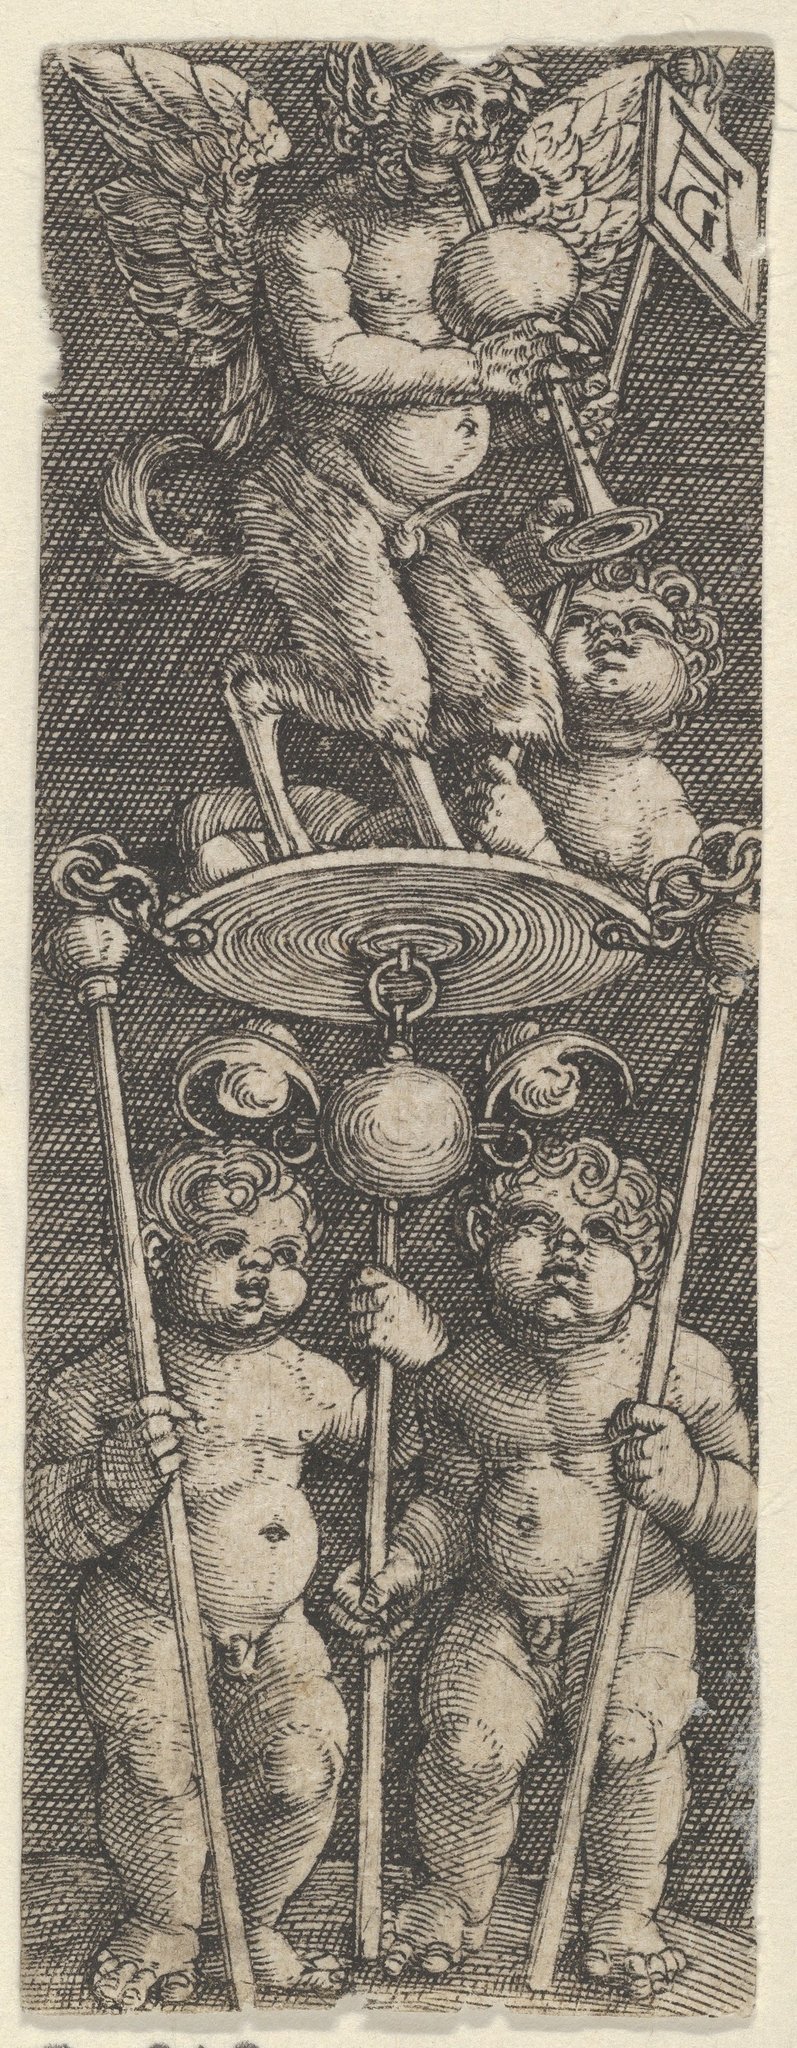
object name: print ornament architecture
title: Vertical Panel with Two Children Supporting a Pedestal with a Satyr Playing a Bagpipe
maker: heinrich aldegrever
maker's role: artist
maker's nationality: german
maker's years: 1502-1561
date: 1527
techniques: engraving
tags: children,bagpipes,satyrs